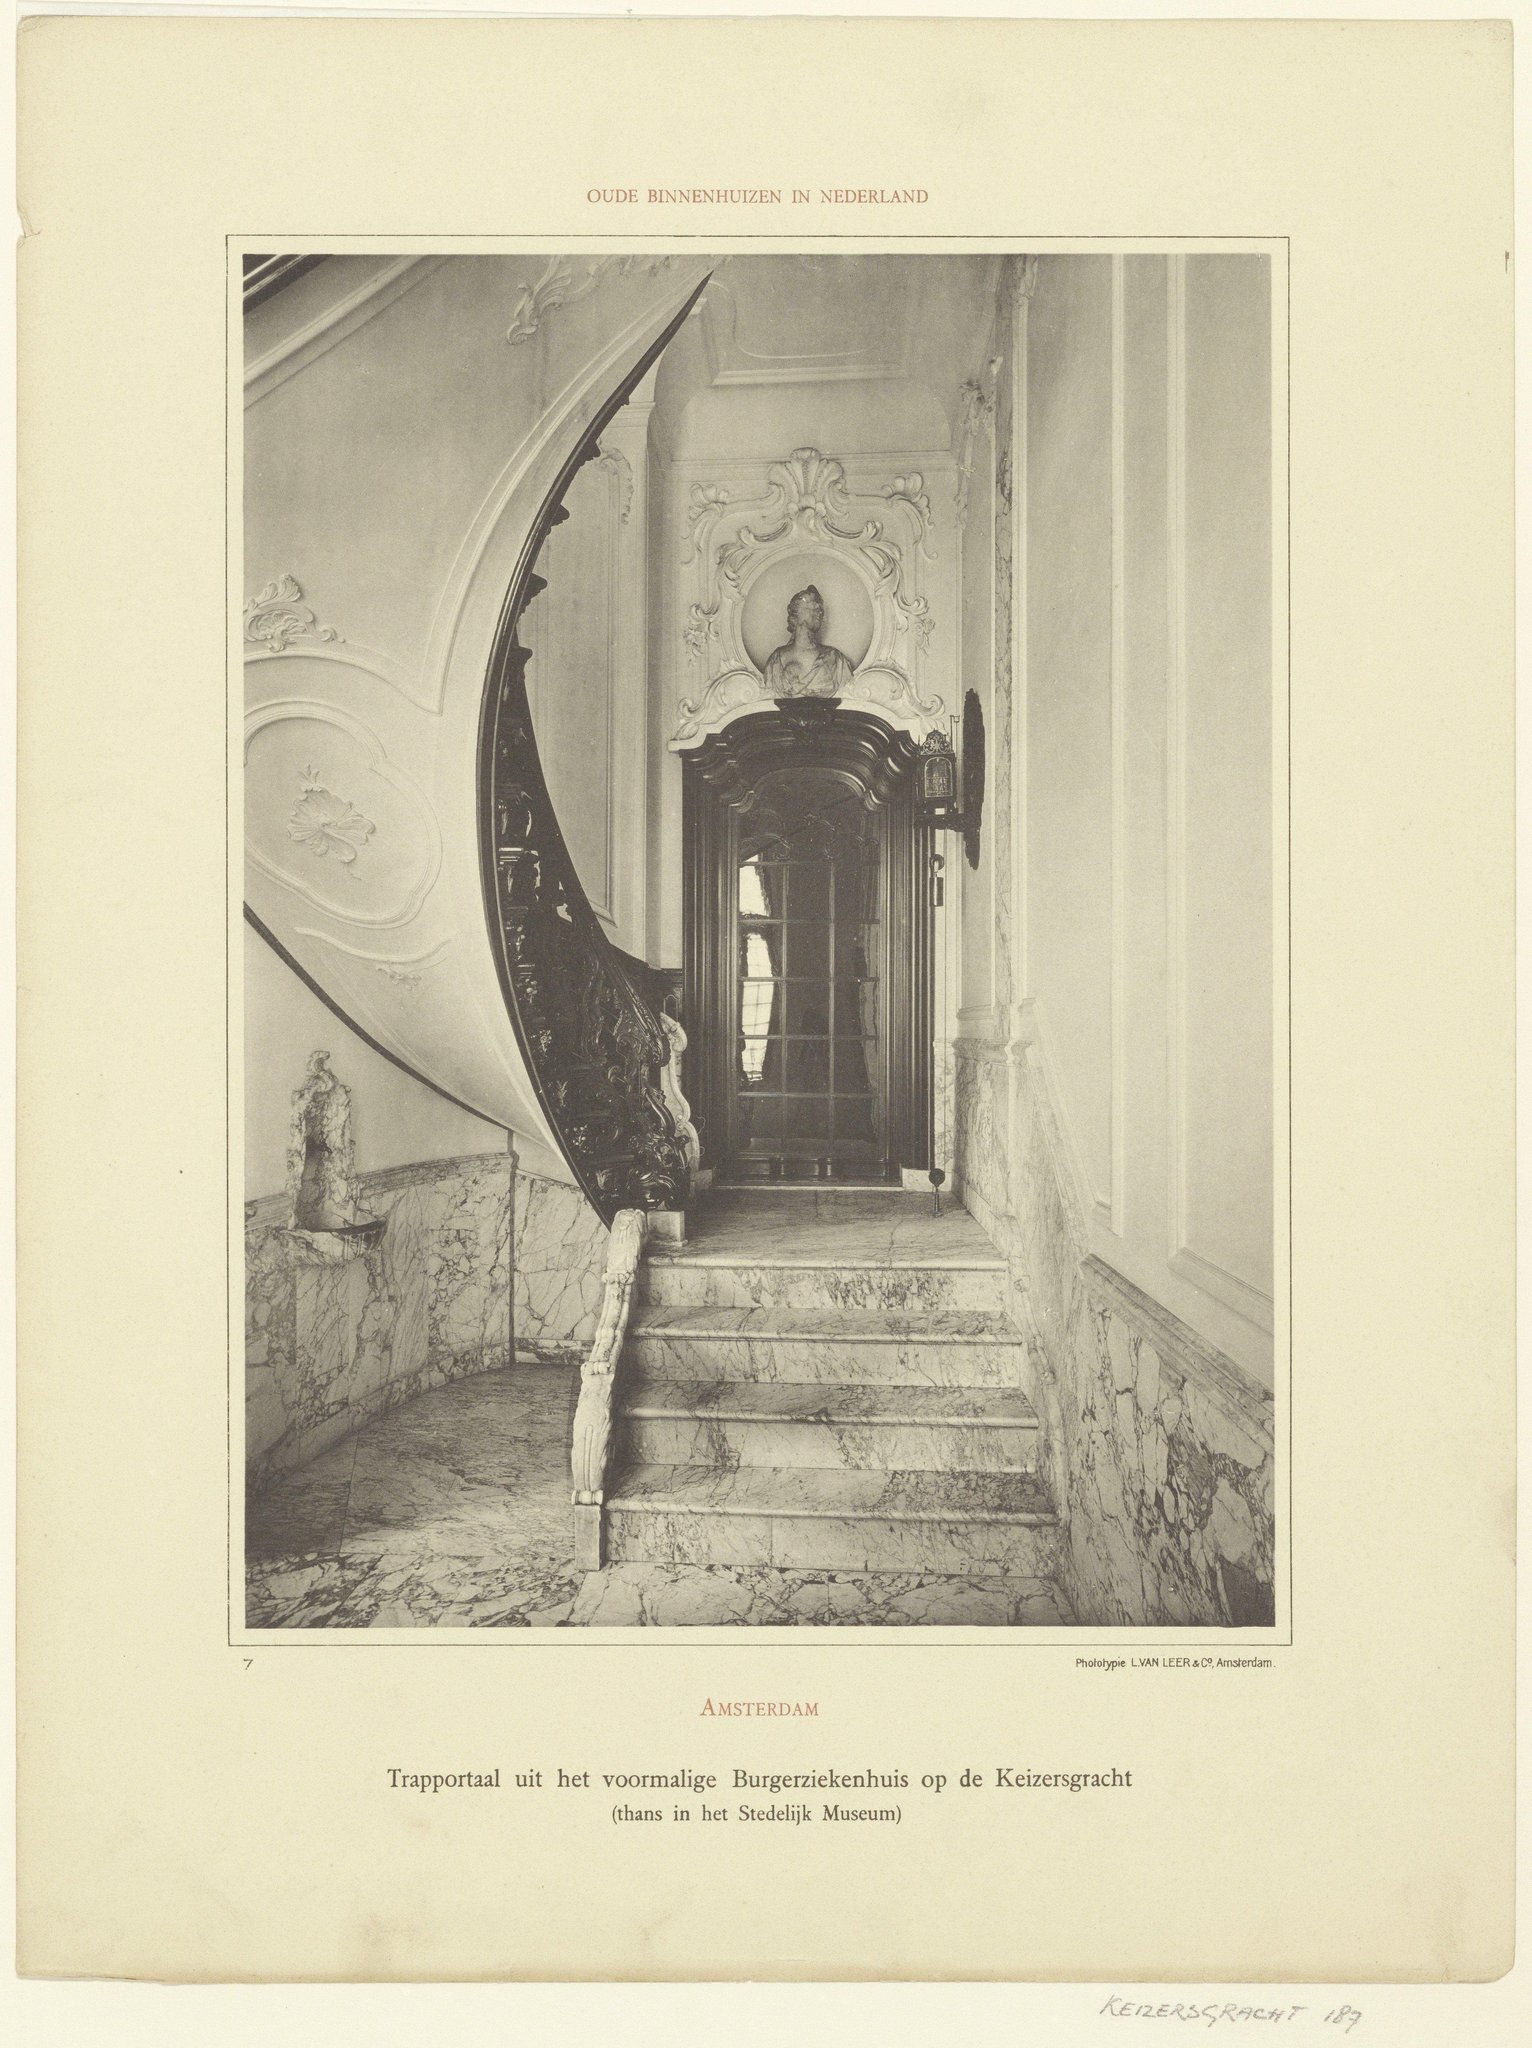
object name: architectural element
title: Trapportaal met wenteltrap uit het pand aan de Keizersgracht 187 te Amsterdam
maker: Anonymous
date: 1740-1760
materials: wood, marble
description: De trap bestaat uit een trapje van drie marmeren treden naar een bordes. Hier begint de wenteltrap met marmeren treden, leuning van mahoniehout en een marmeren lambrisering. De wanden zijn met stucwerk versierd. Onderaan de wenteltrap zit ook versierd stucwerk. Boven en doorgang vanuit het bordes is een nis met een marmeren beeld. Onder de trap is een fonteintje.